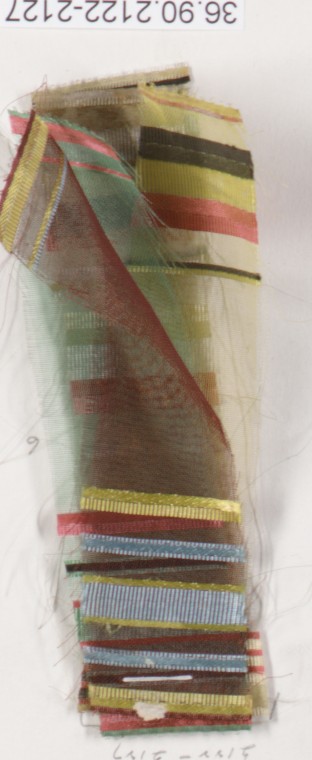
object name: piece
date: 1801-1900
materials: silk